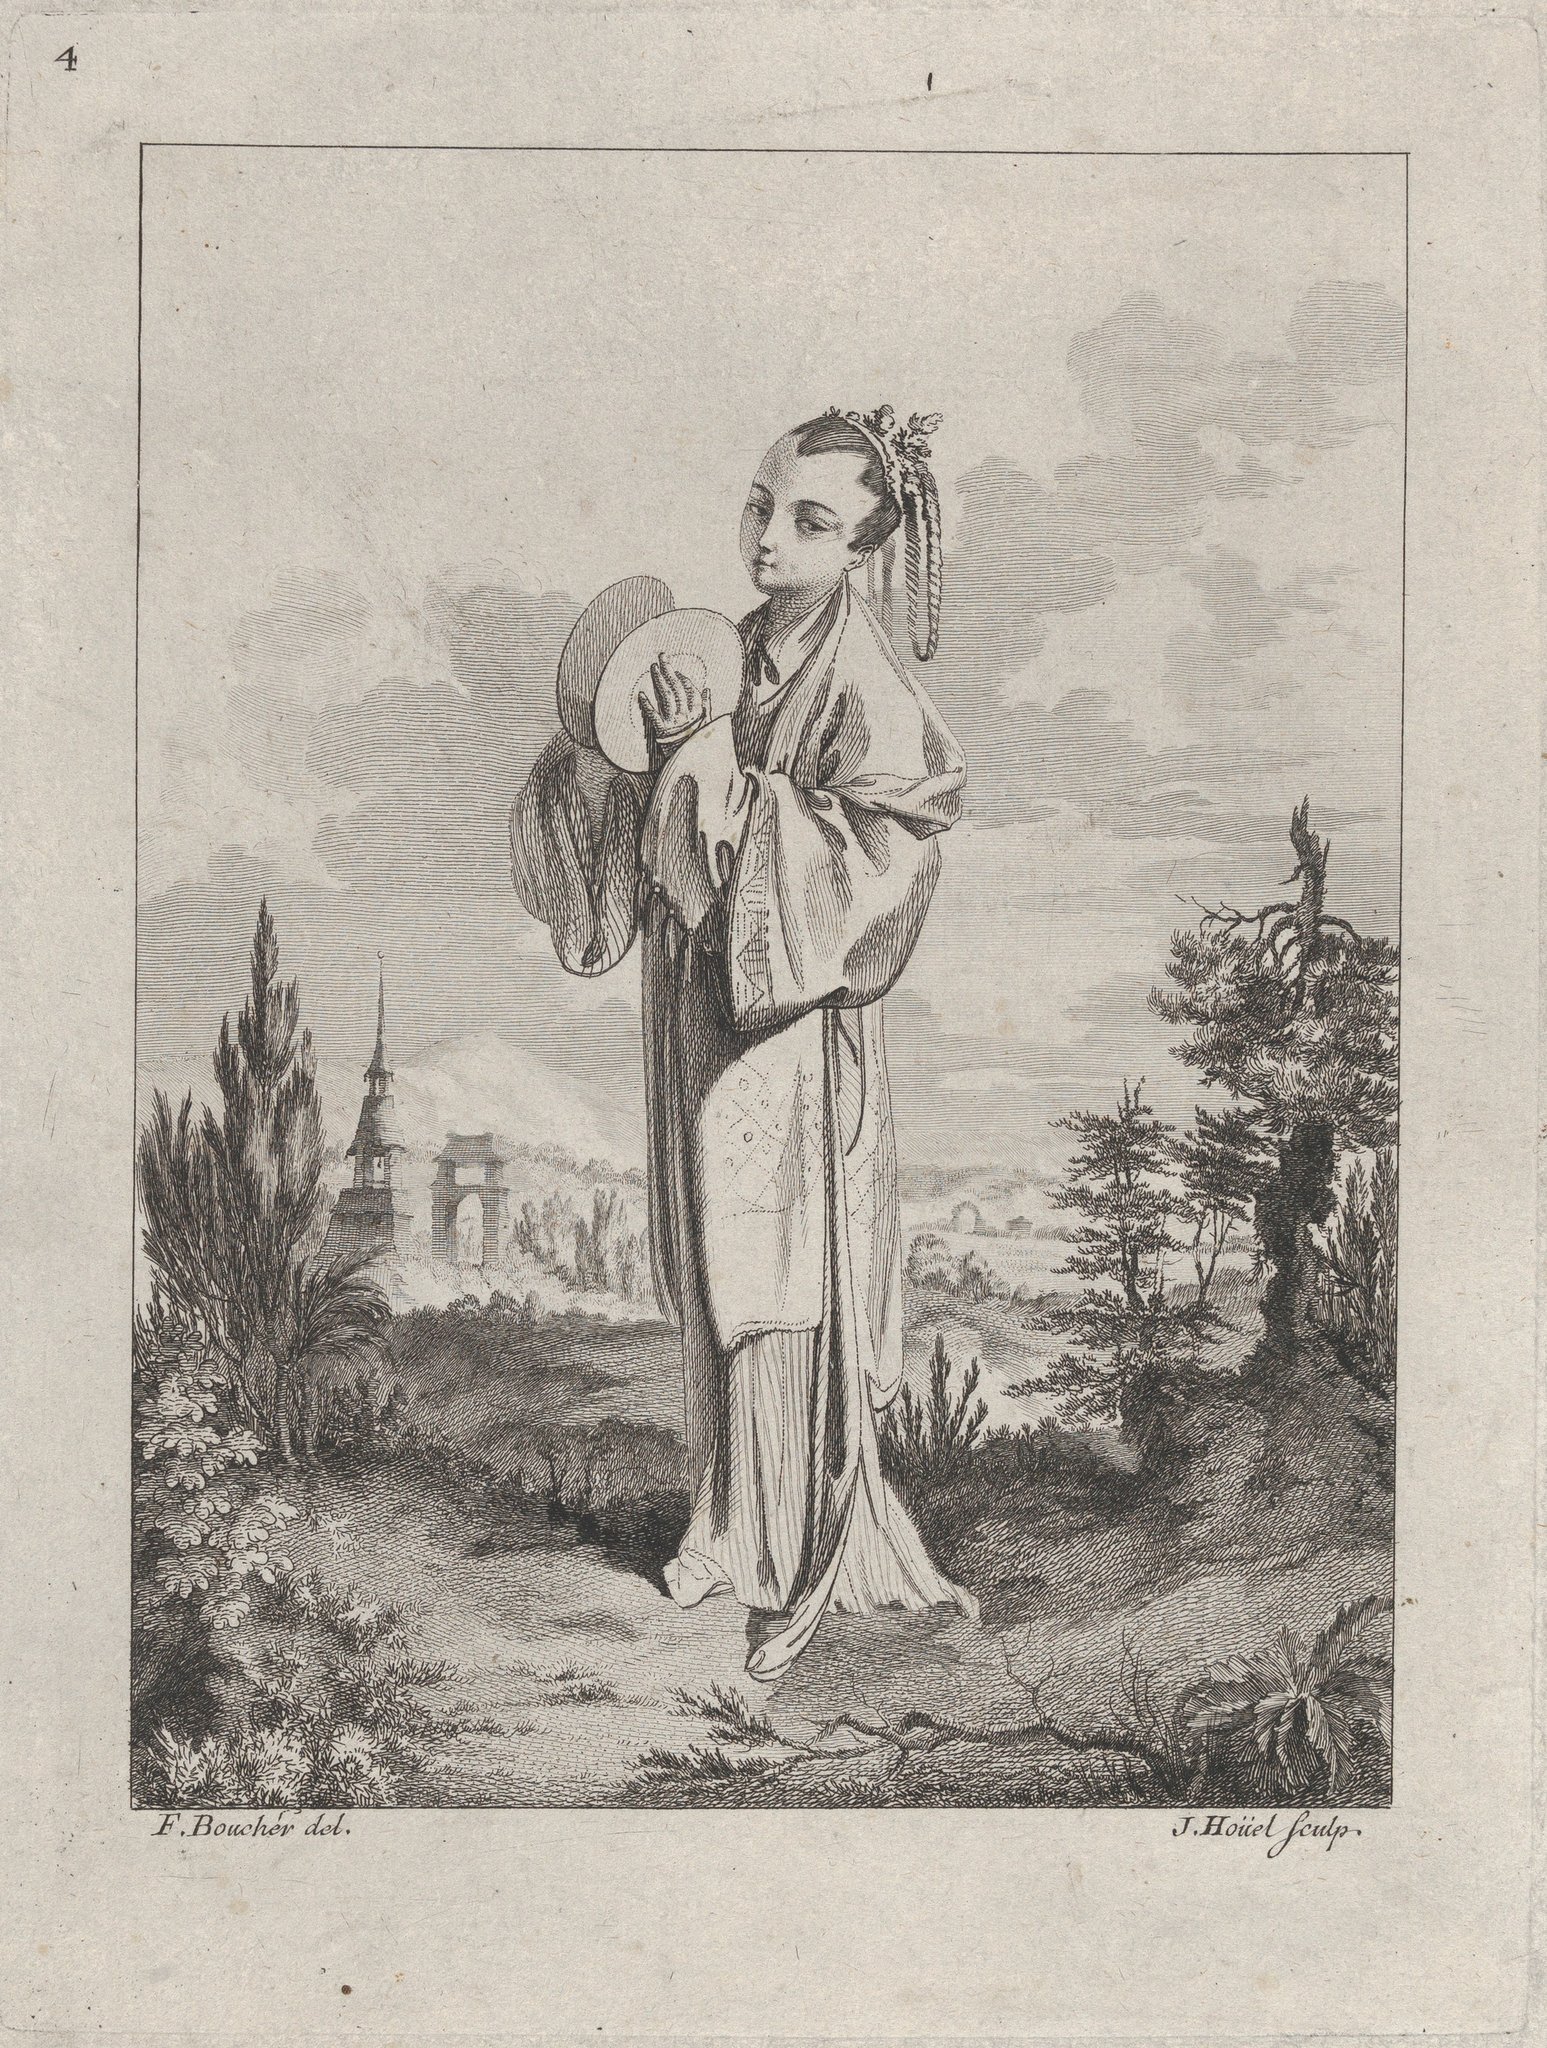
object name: print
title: Chinoiserie with a woman holding cymbals, from Suite de Figures Chinoises. . .Tiré du Cabinet de Mr. d'Azaincourt (Series of Chinoiserie Figures. . .From the Chambers of Mr. d'Azaincourt), plate 4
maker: jean pierre louis laurent hoüel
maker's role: artist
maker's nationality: french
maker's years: 1735-1813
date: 1755-1776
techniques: engraving, etching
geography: france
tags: chinoiserie,women